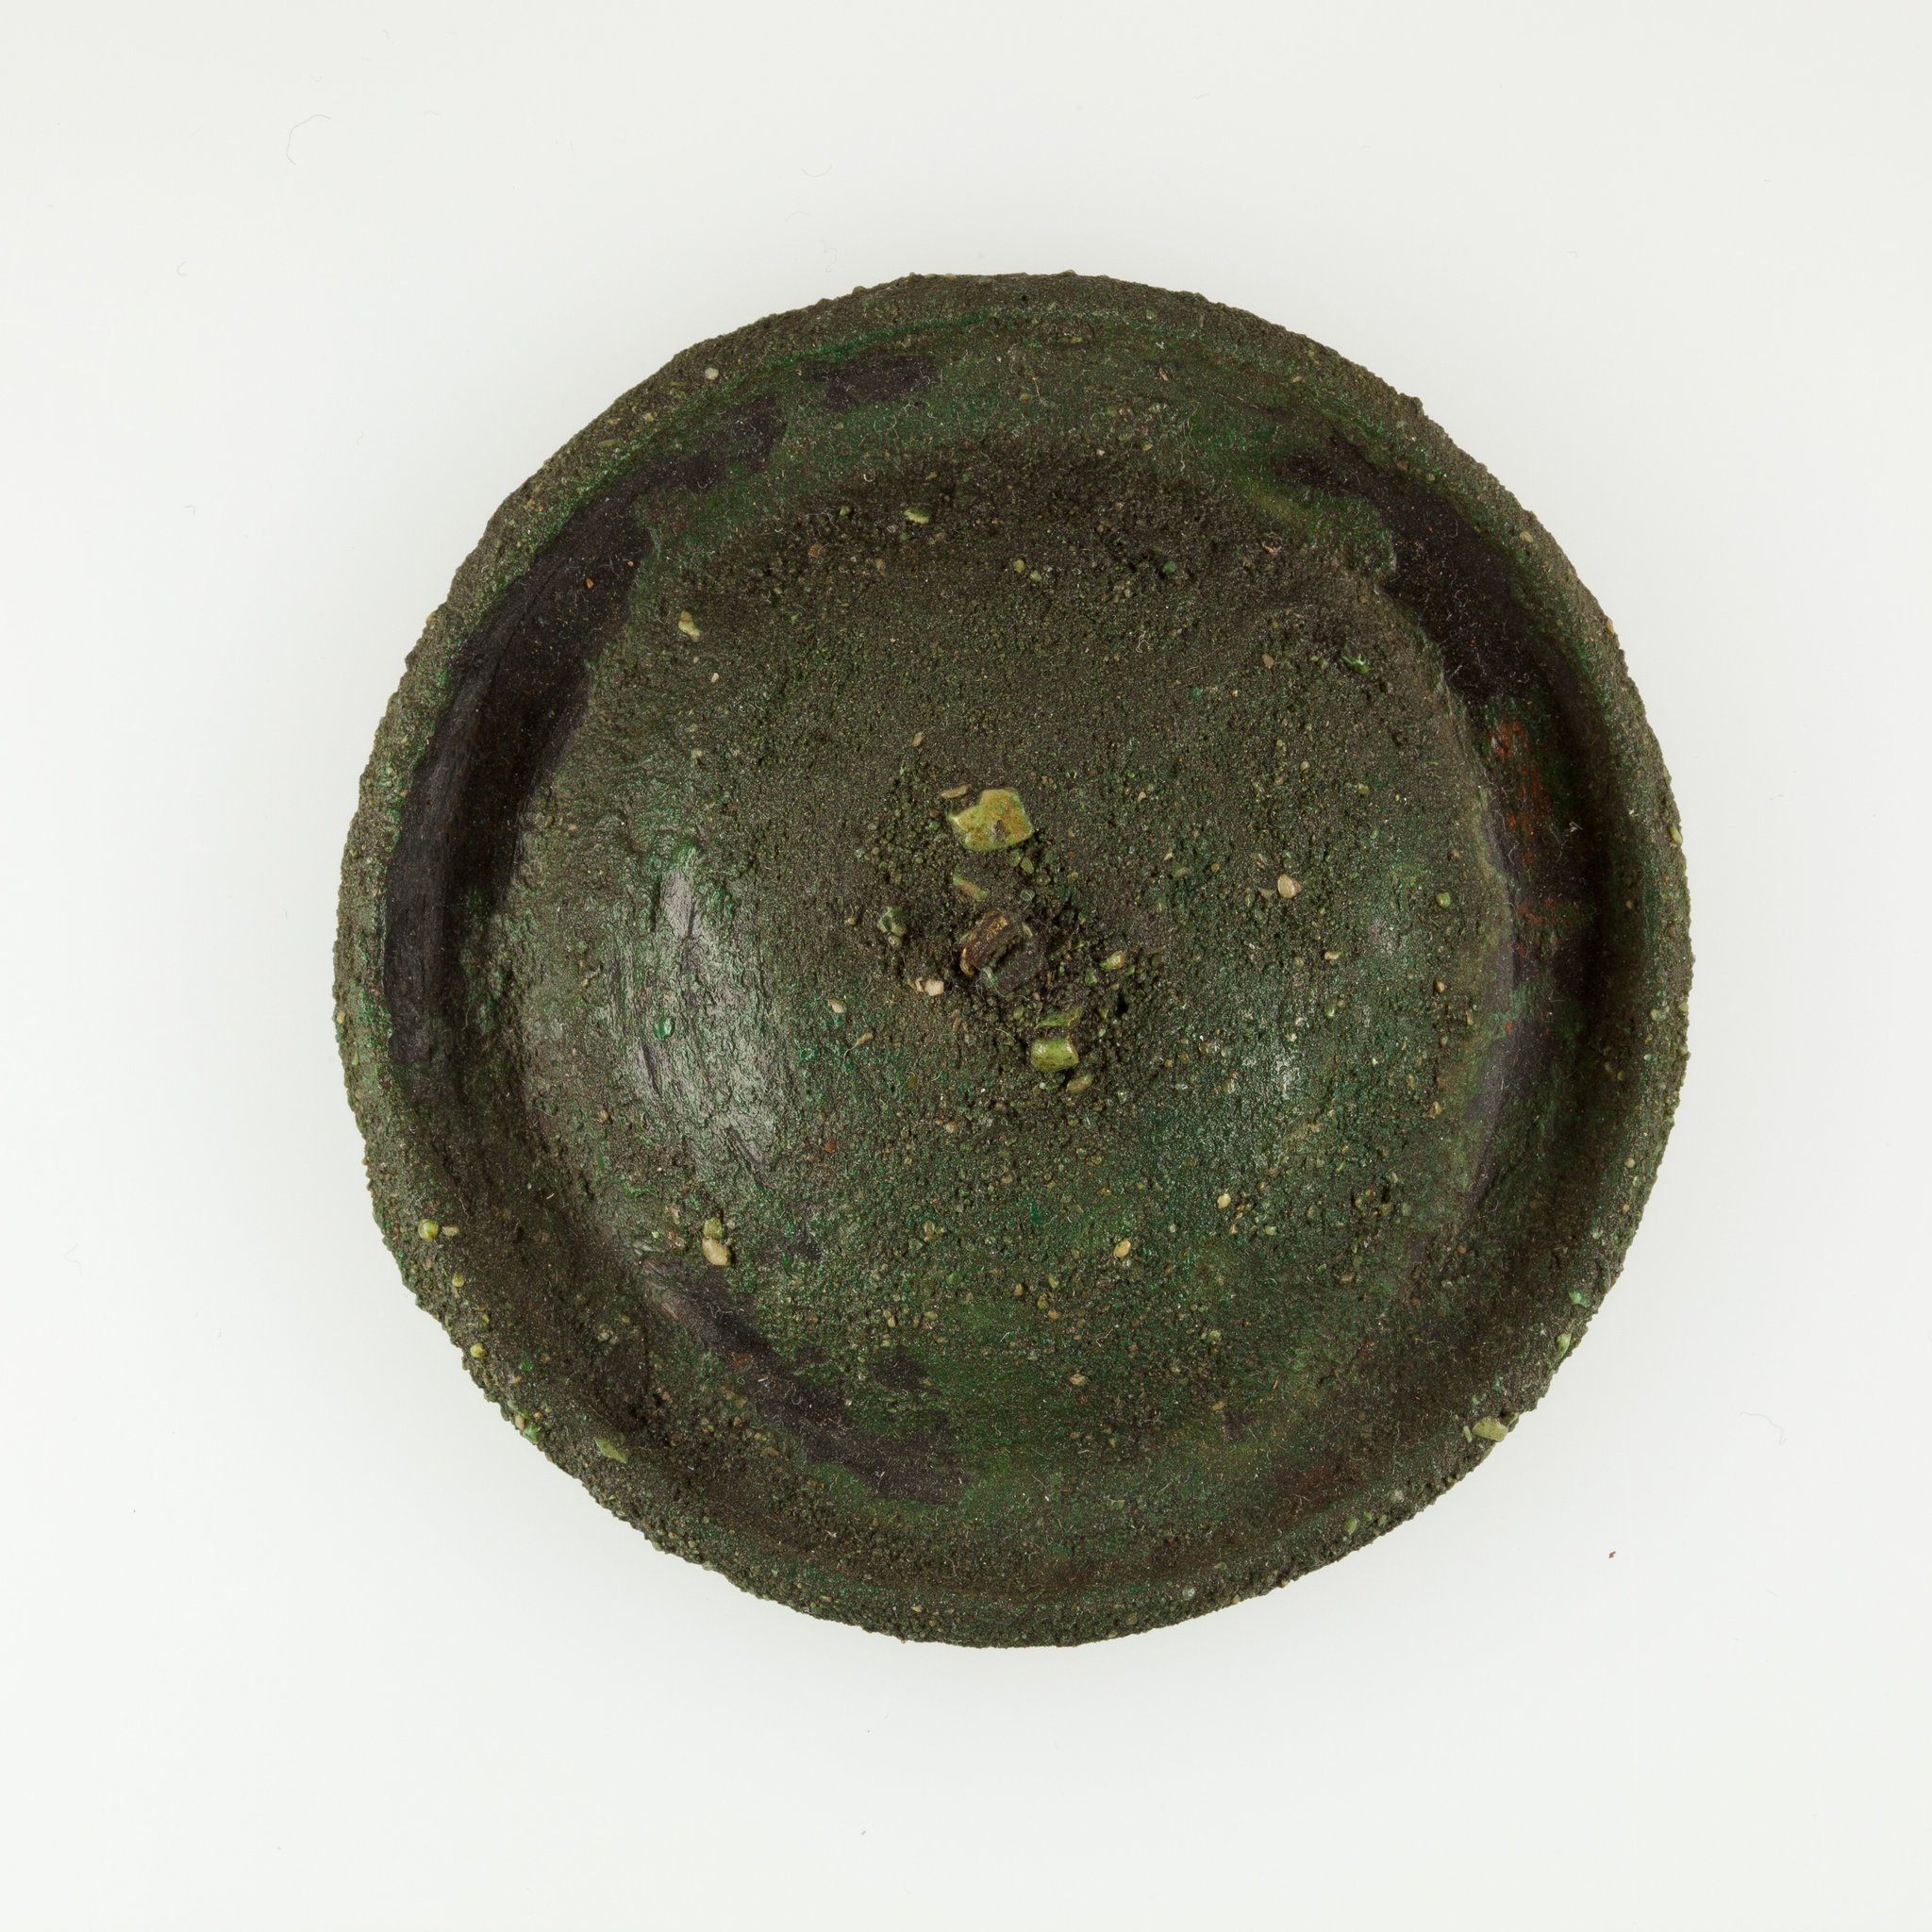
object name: music, cymbal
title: Cymbal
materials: copper alloy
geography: egypt